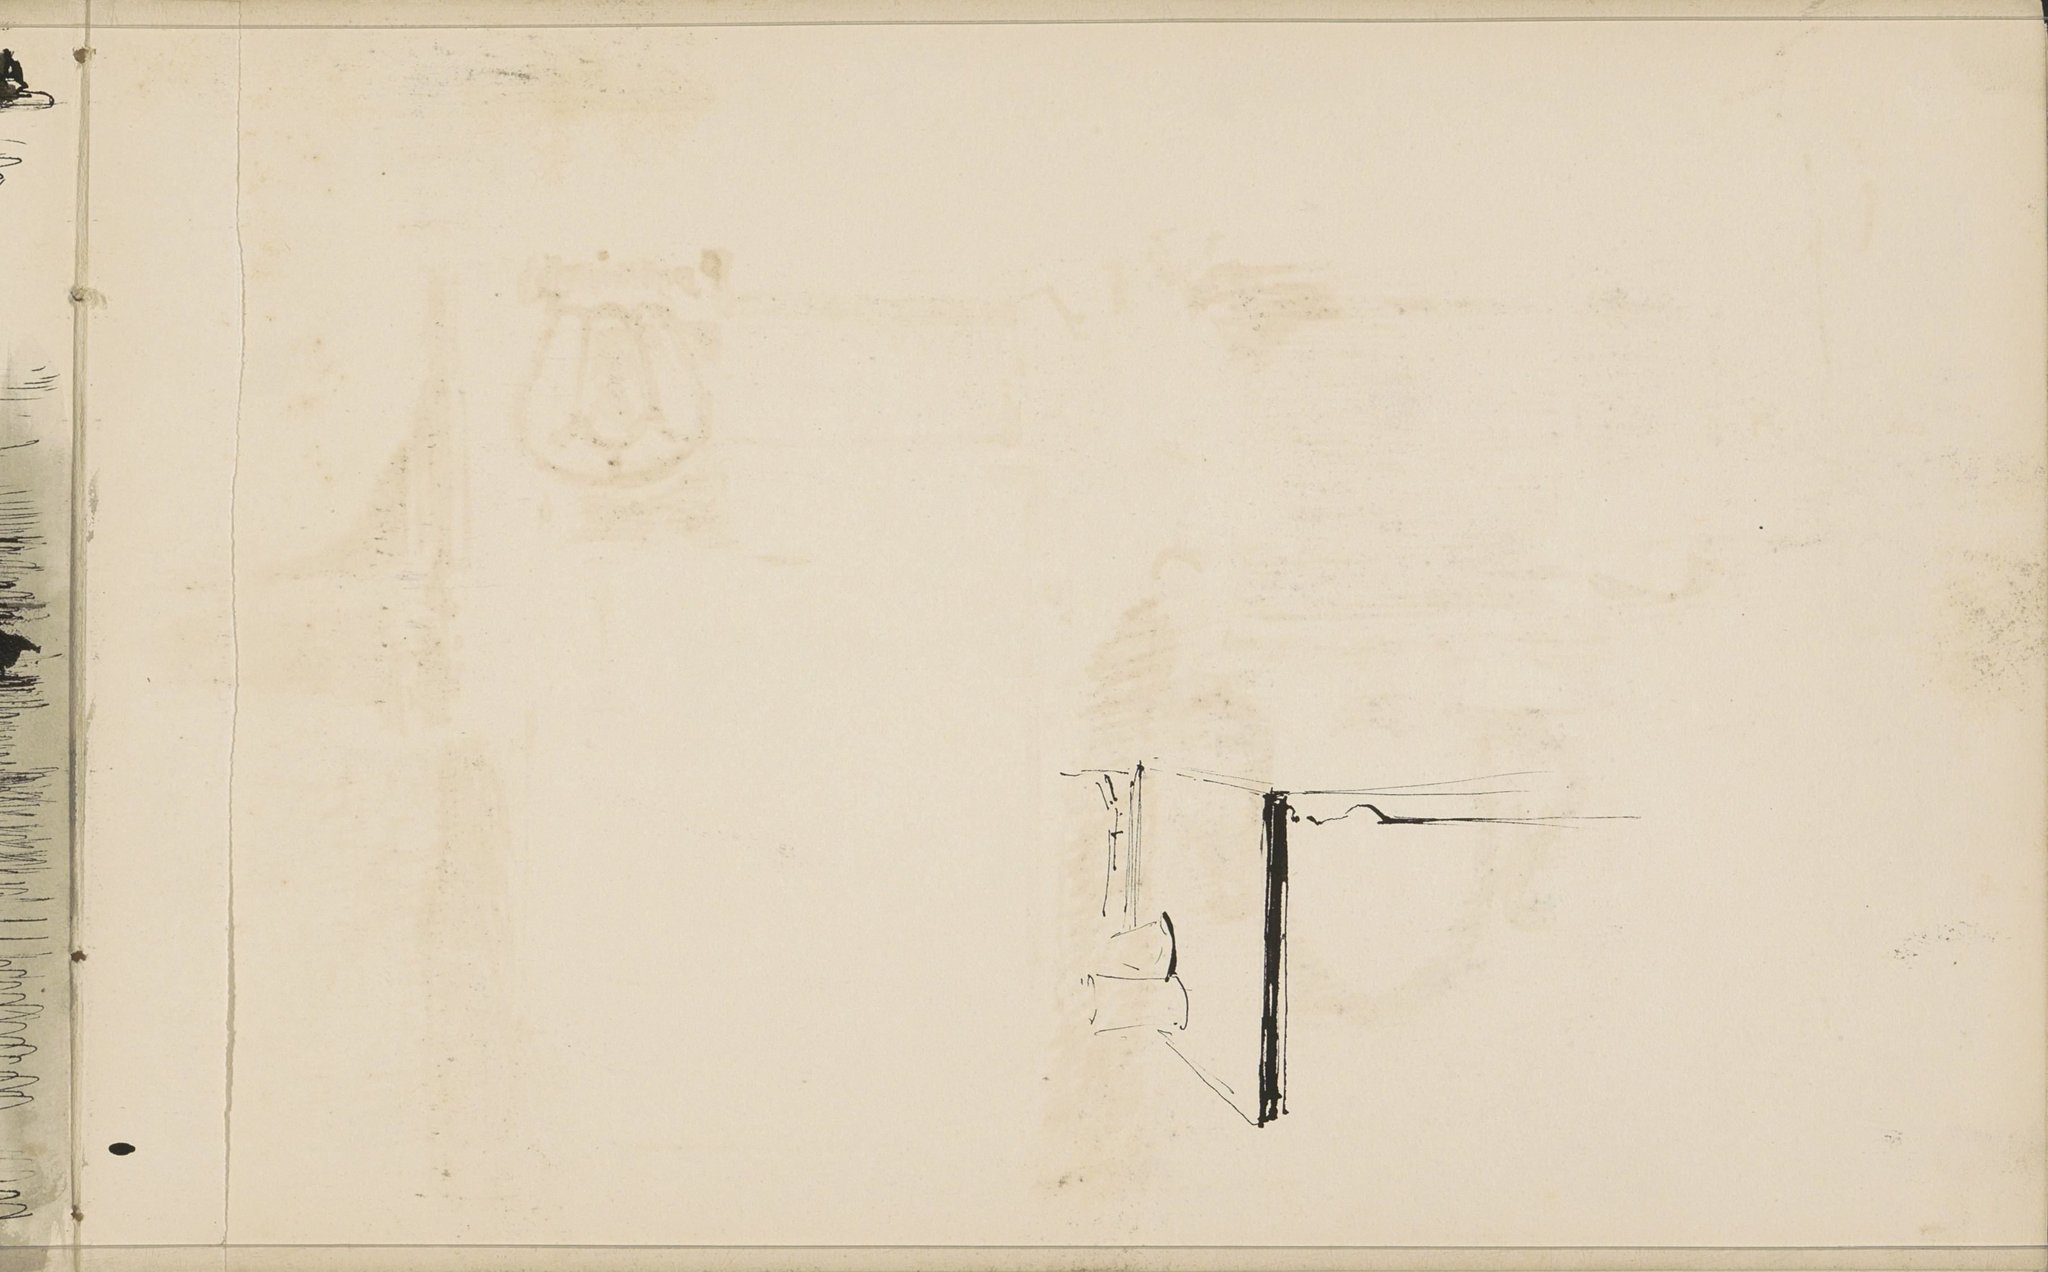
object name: sketchbook leaf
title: Studie, mogelijk een deel van een interieur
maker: a.a.l. de grammont-hubrecht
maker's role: draughtsman, painter, print maker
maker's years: 1855-1913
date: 1865-1913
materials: ink, paper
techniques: pen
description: Blad 38 recto uit een schetsboek met 65 bladen.